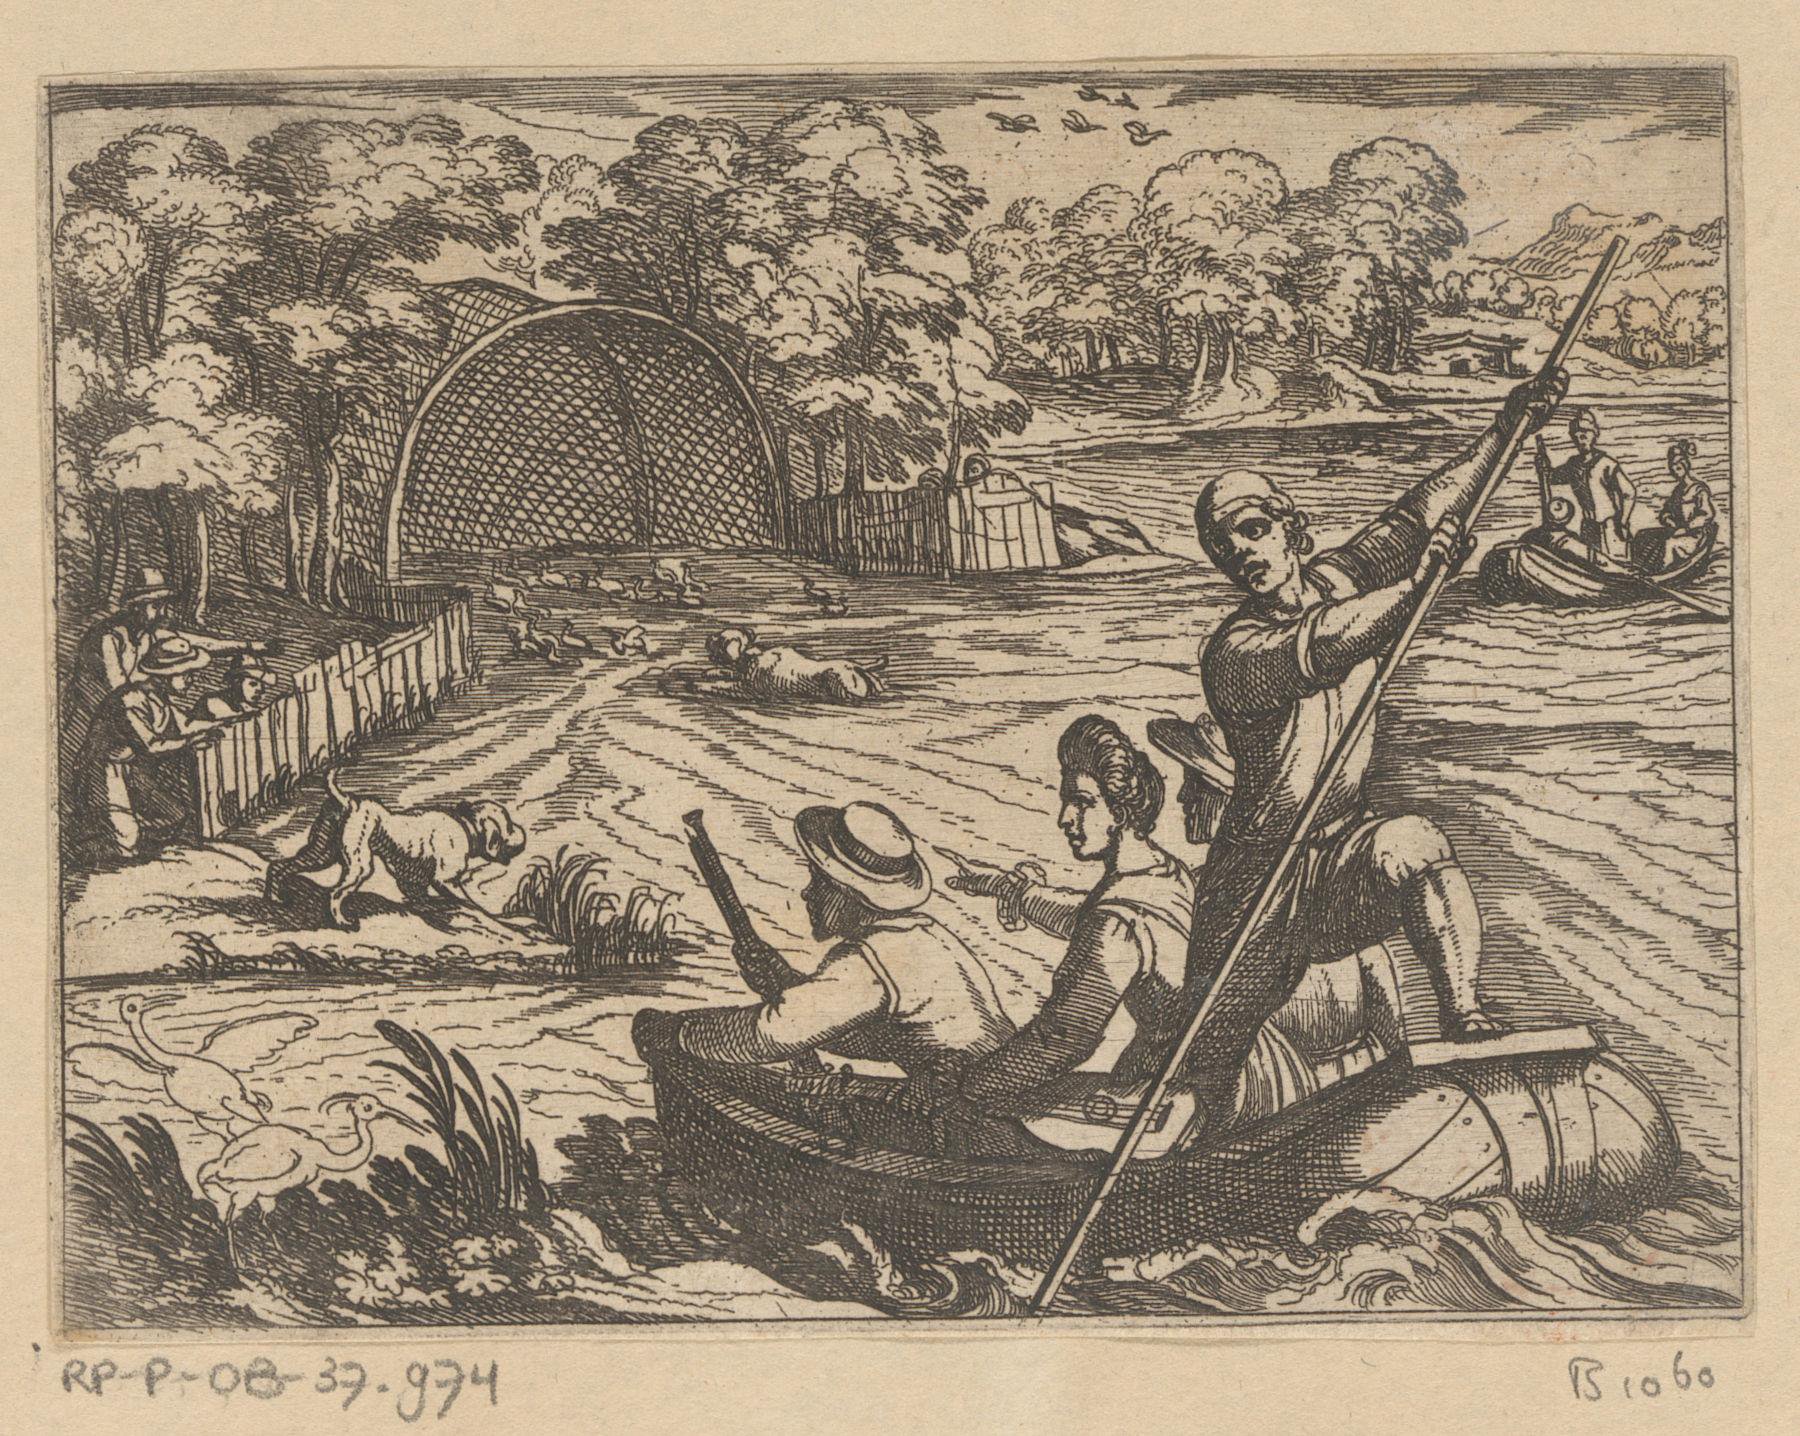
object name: print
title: Jagers drijven wilde ganzen in een groot net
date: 1598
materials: paper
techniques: etching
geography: vatican city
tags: hunter, hunters hunting (n.b.: in 1988-1990 this notation denoted the concept of 43c11421 'hunters resting during the hunt'), bird hunting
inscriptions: collector's mark: Lugt 240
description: Jagers op bootjes en aan de waterkant drijven ganzen met behulp van honden in een groot net.